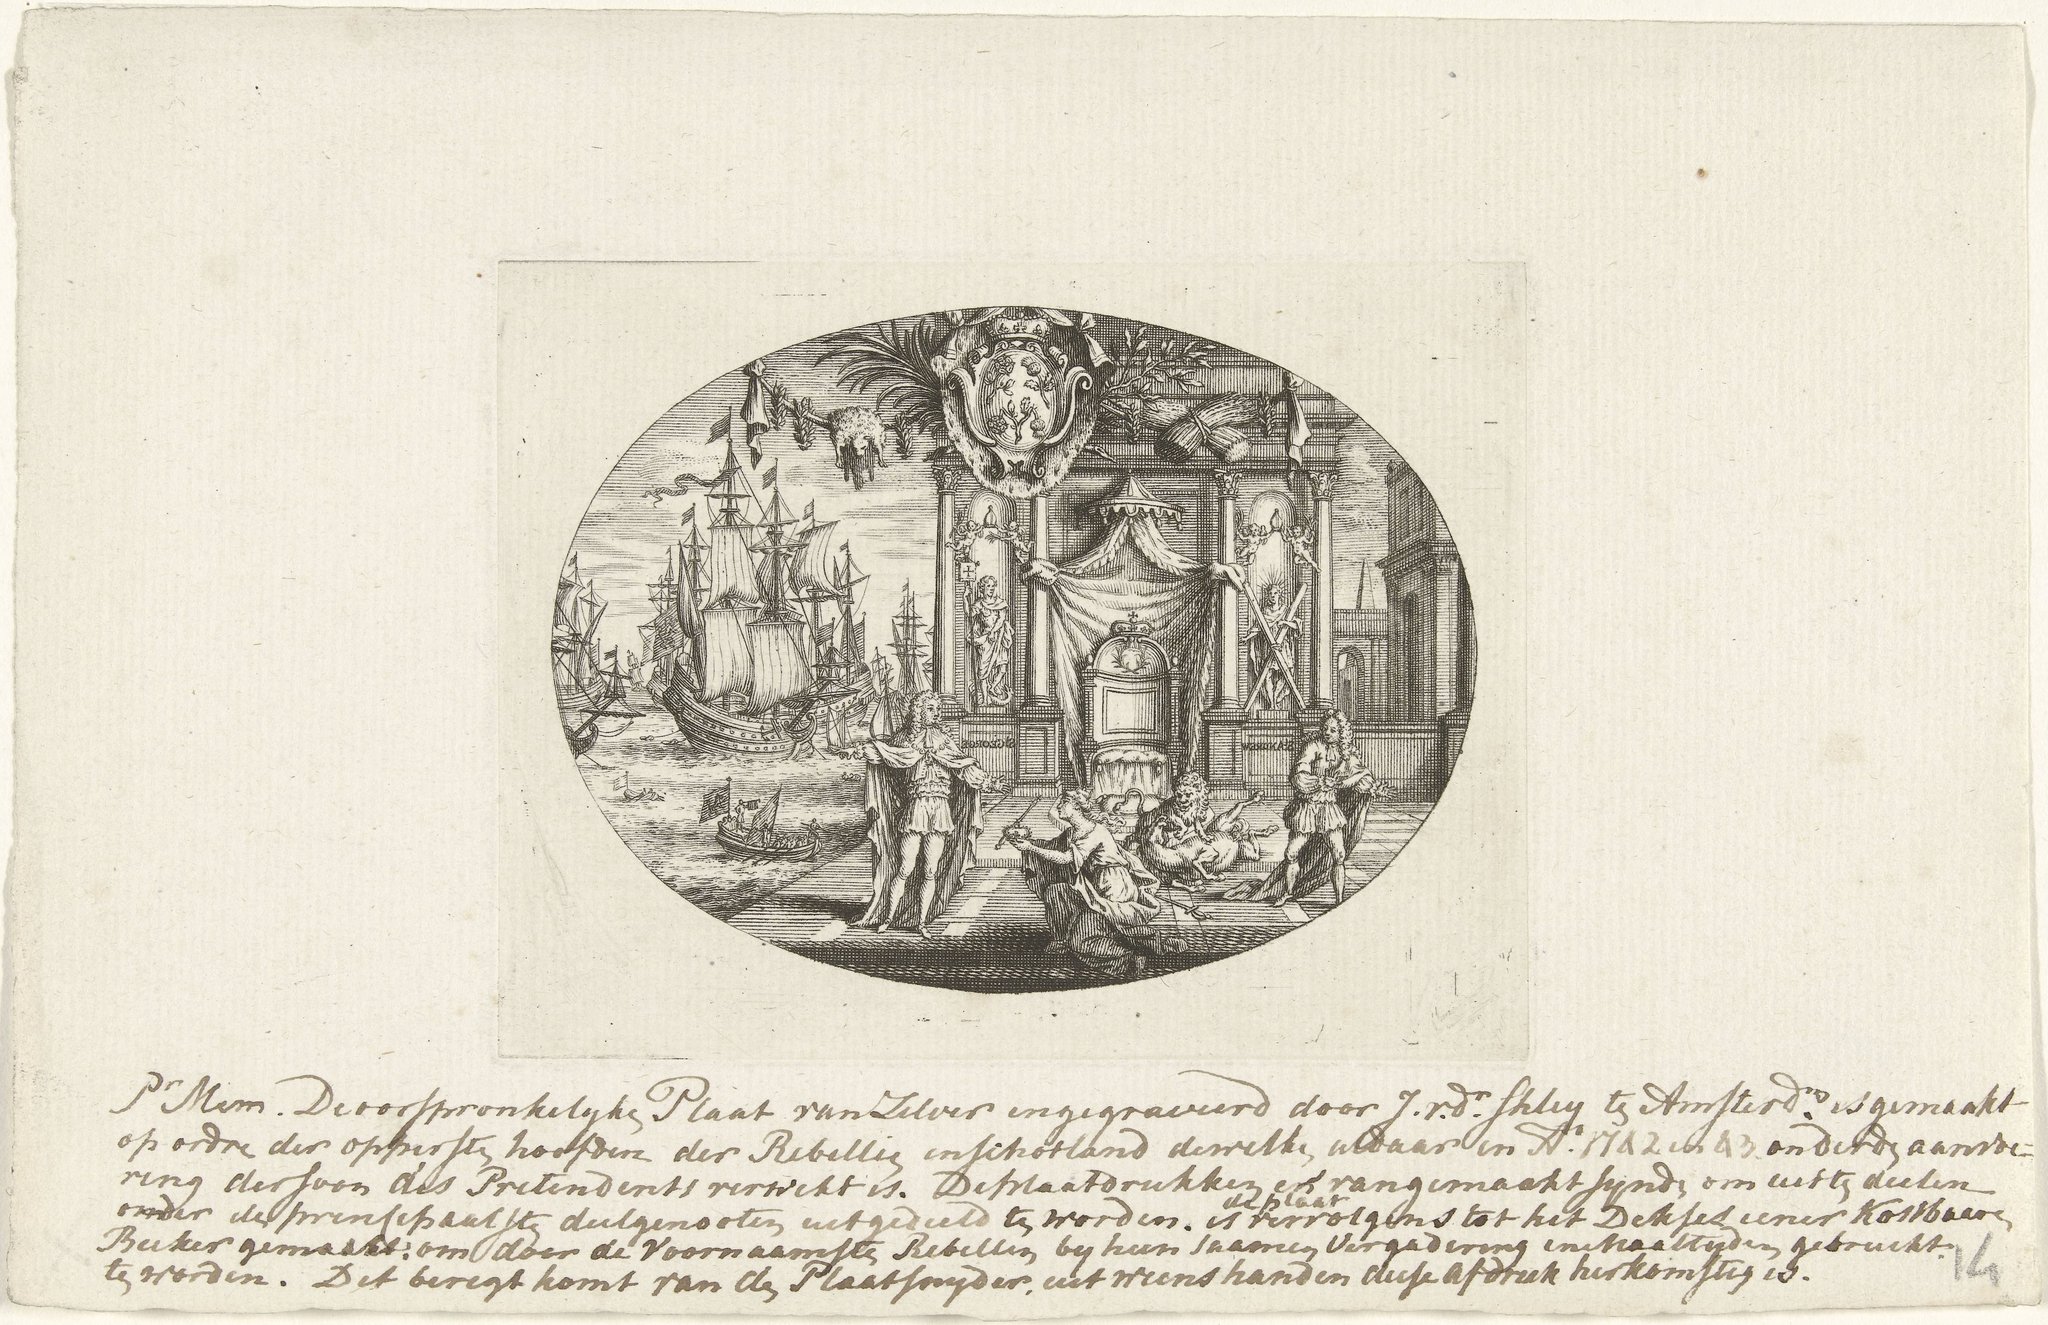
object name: print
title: Allegorie op de aankomst en machtsovername van Karel Eduard Stuart, 1745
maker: jacob van der schley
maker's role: draughtsman, print maker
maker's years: 1715-1779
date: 1745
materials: paper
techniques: engraving, etching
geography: northern netherlands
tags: karel eduard stuart, tweede jacobitische opstand (1745-1746)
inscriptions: collector's mark: Lugt 2228, inscription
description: Allegorie op de Tweede Jacobitische Opstand met de aankomst van de vloot en gewenste machtsovername van Karel Eduard Stuart, 1745. De Britse Maagd biedt Karel de koningskroon en scepter aan. Een leeuw overwint de Britse eenhoorn. Op het blad een uitgebreid opschrift over het ontstaan van de plaat volgens welke de zilveren plaat in opdracht van de opstandelingen te Amsterdam is gemaakt en werden de afdrukken verdeeld onder de rebellen. De zilveren plaat zou vervolgens verwerkt zijn tot het deksel van een beker waaruit de rebellen dronken.